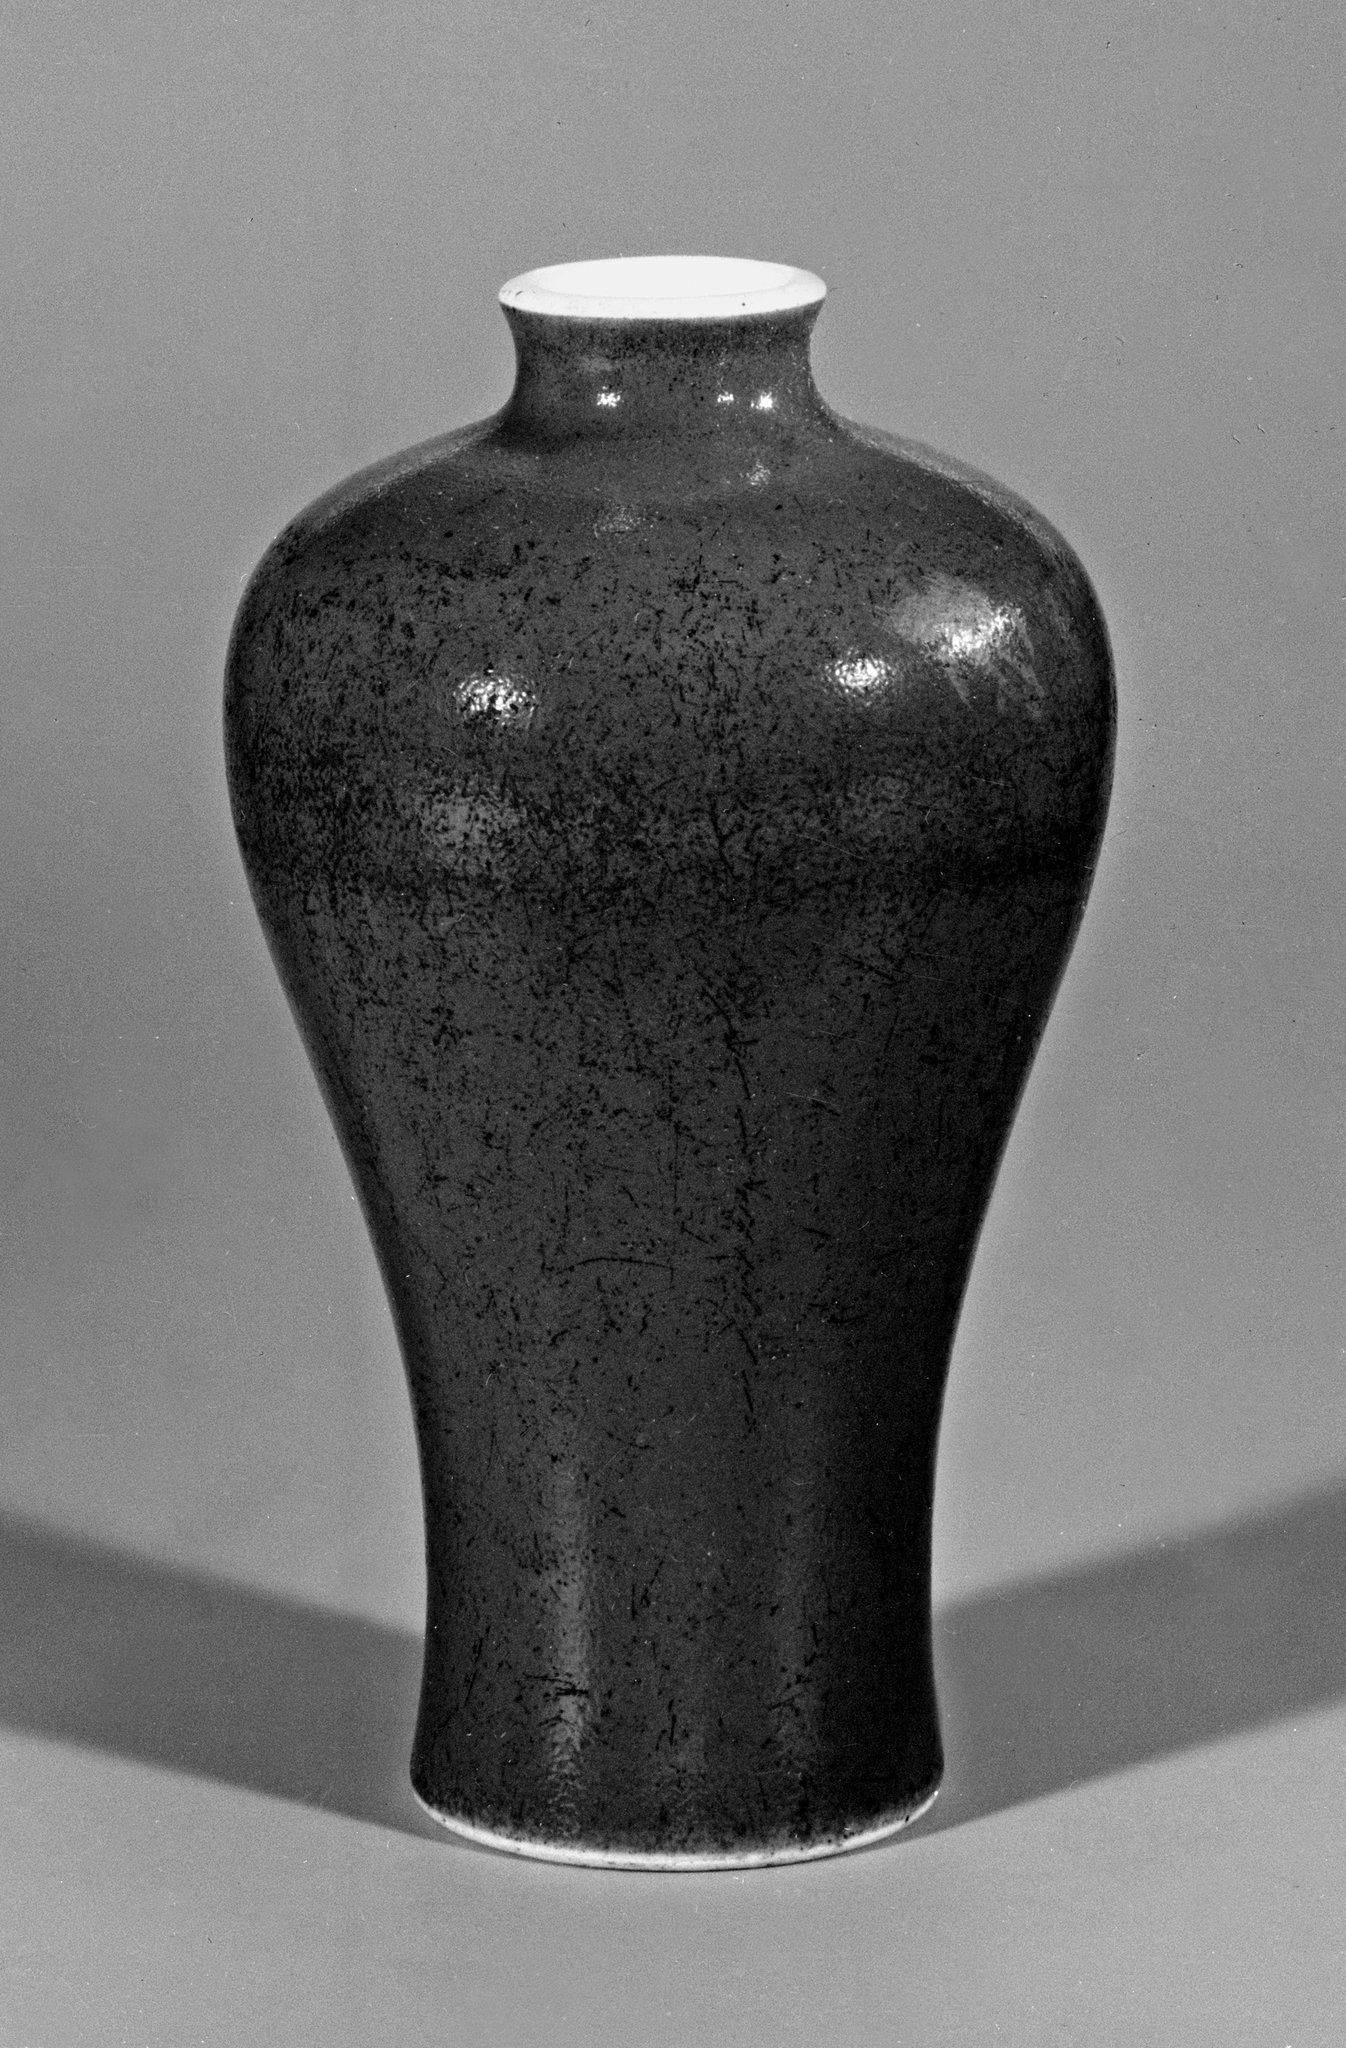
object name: vase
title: Meiping vase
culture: chinese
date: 1767-1800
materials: glaze, porcelain